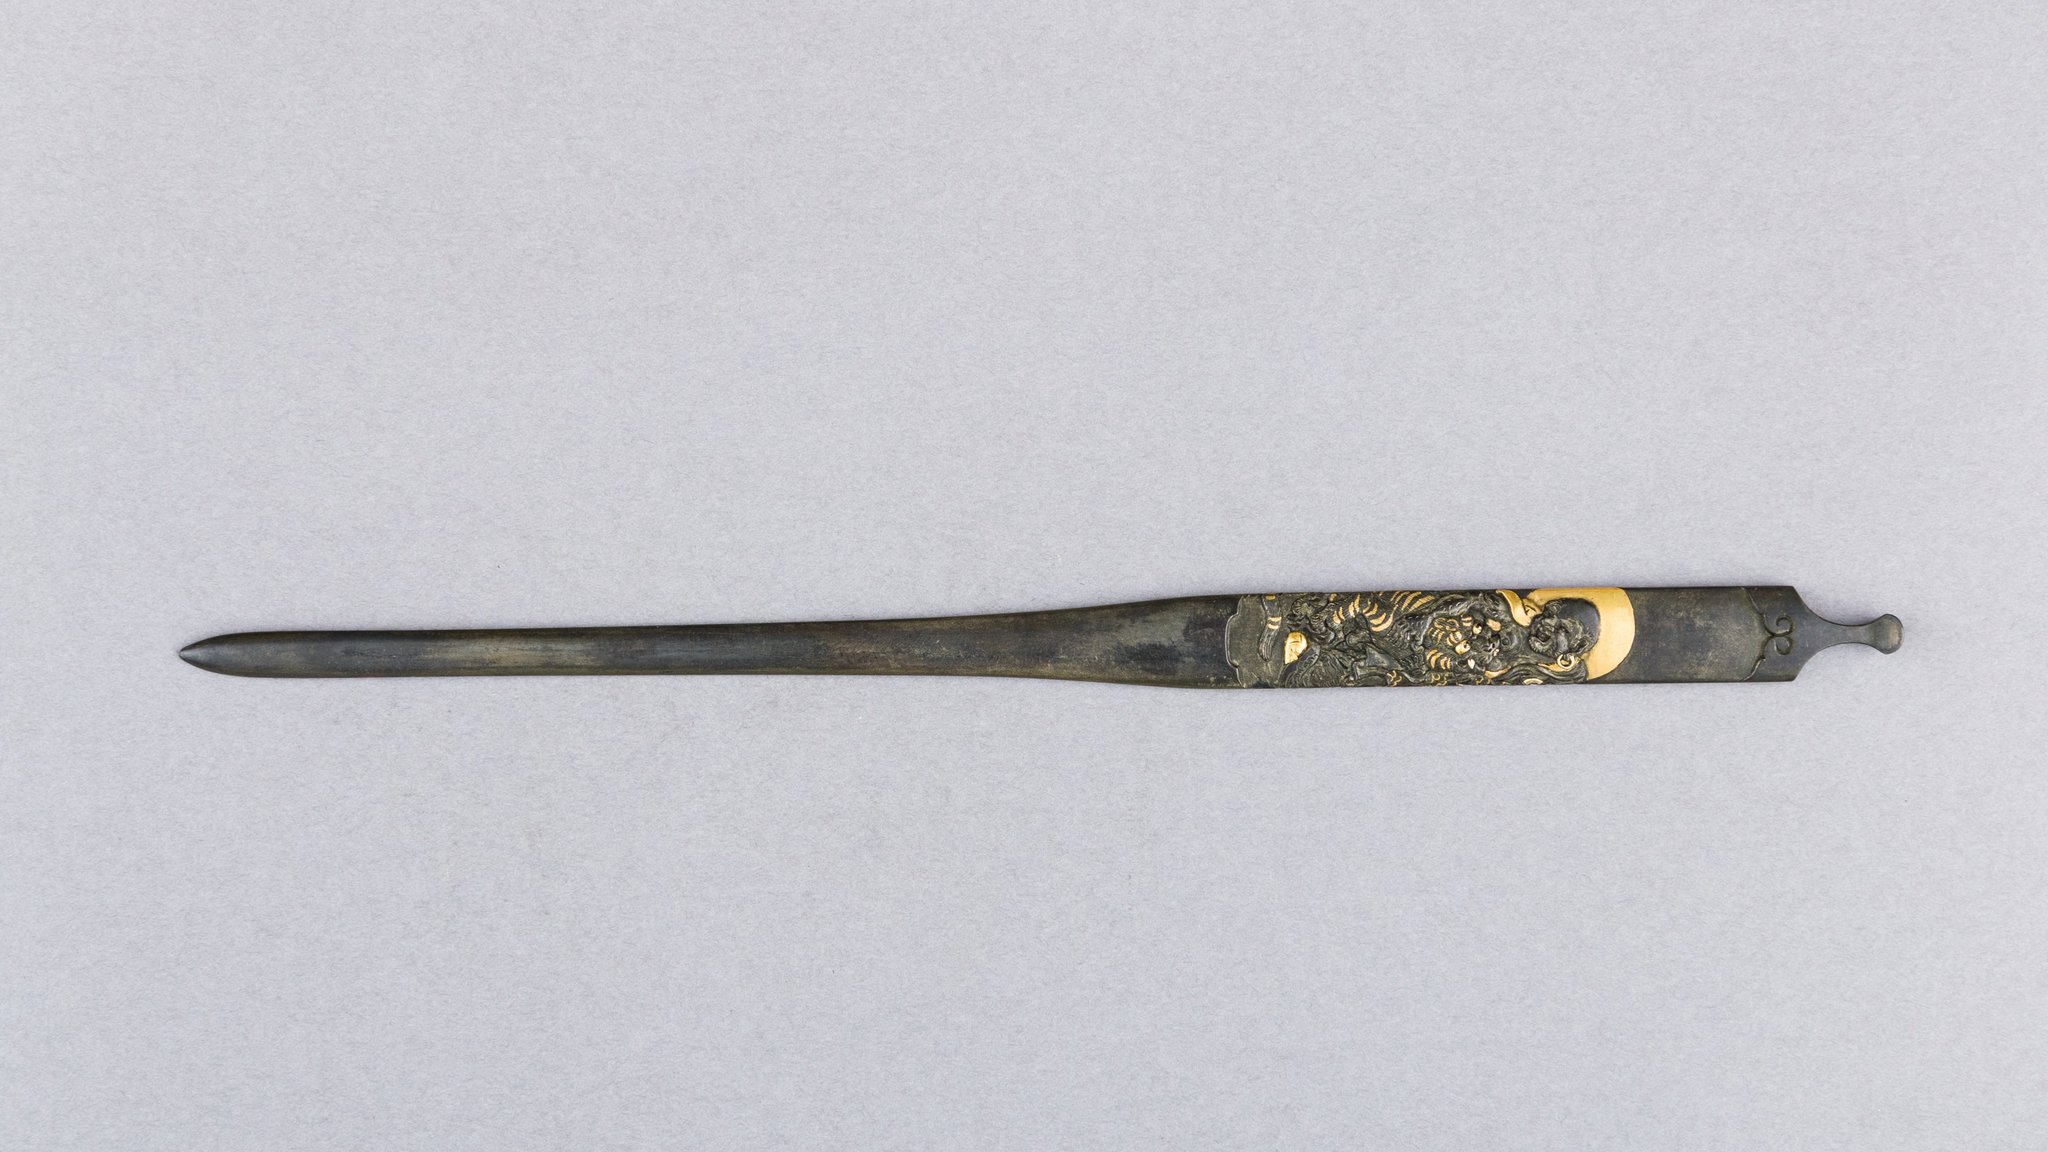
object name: hair dressing tool kogai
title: Hair Dressing Tool (Kogai)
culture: japanese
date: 1615-1868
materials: silver alloy, gold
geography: japan